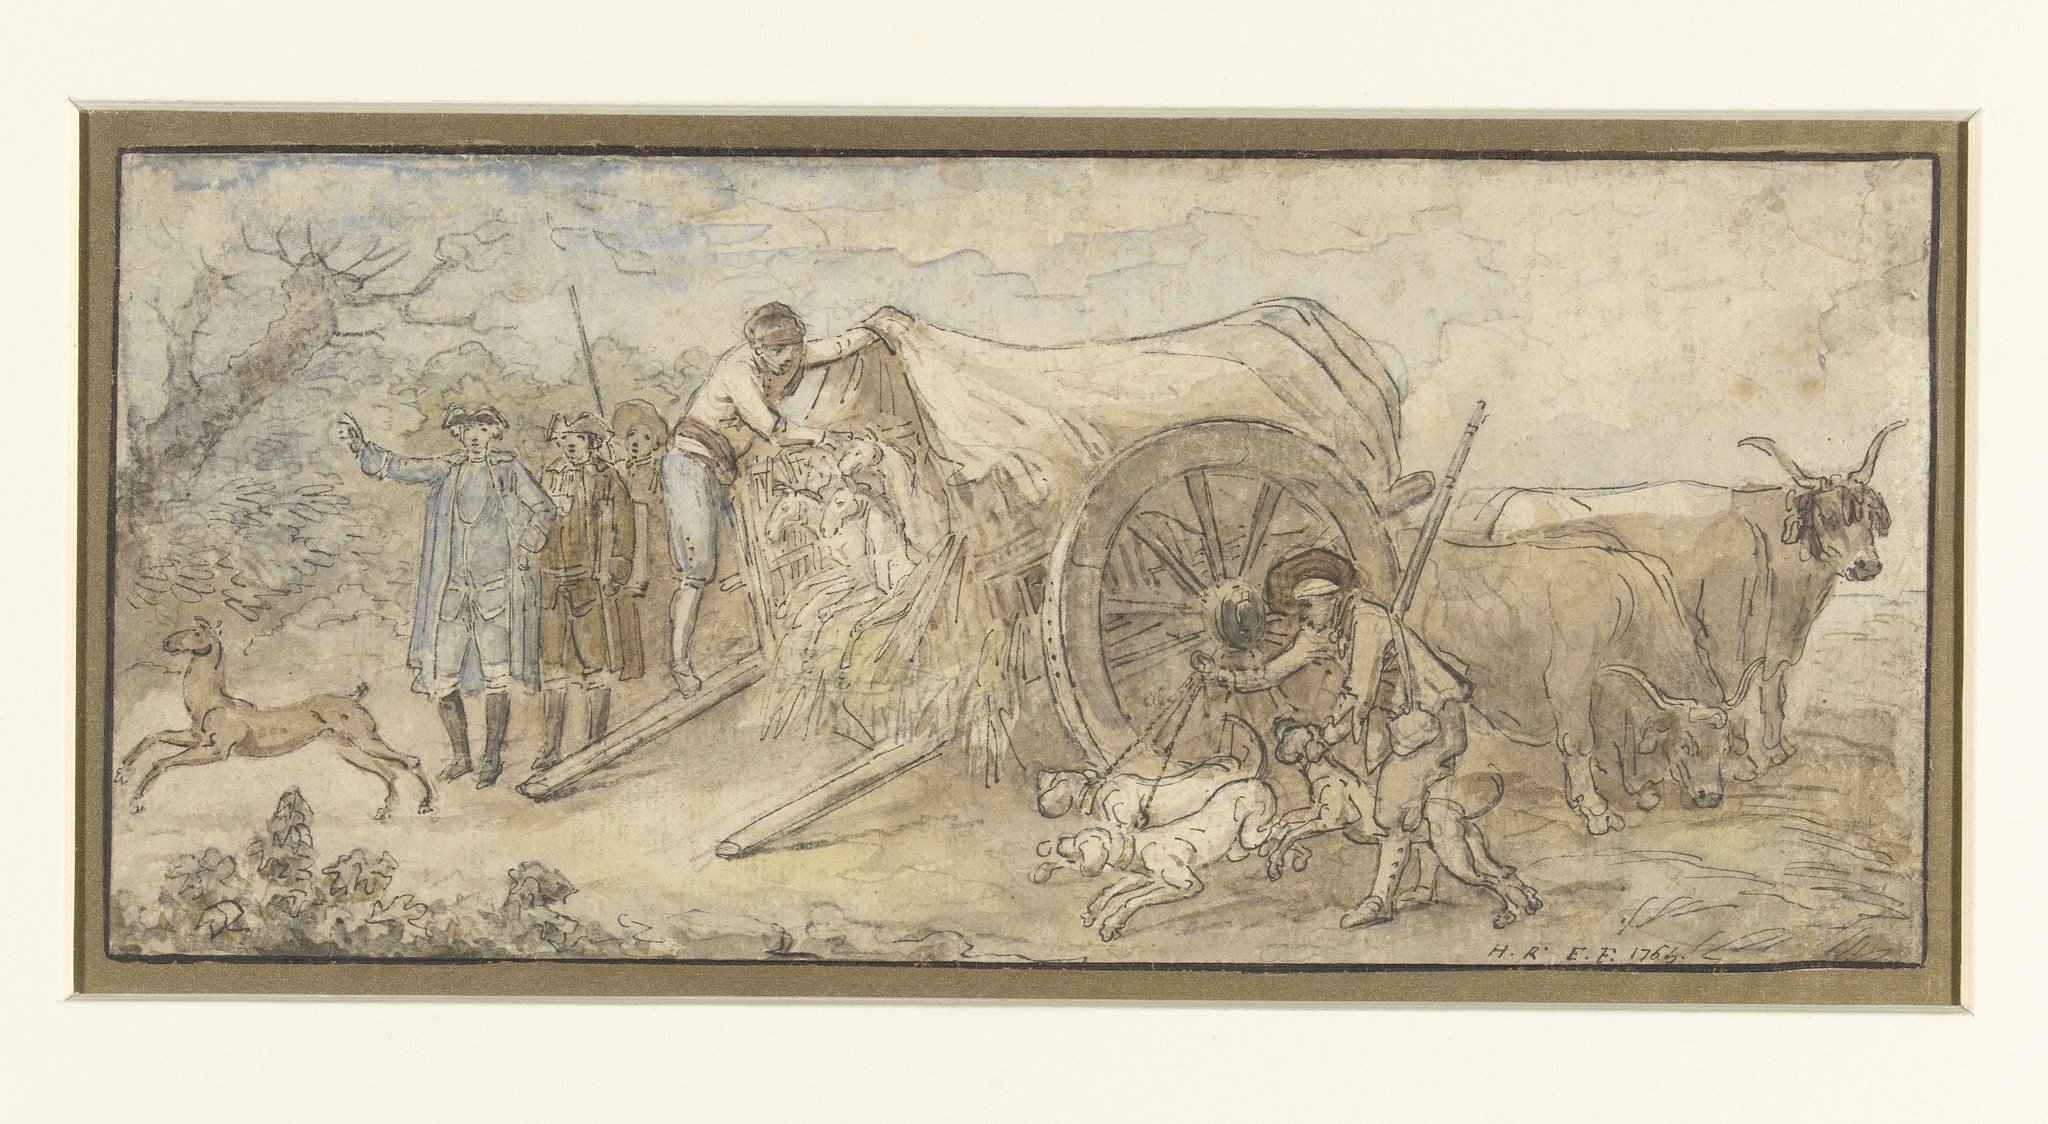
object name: drawing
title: Huifkar in de Campagna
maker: hubert robert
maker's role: draughtsman, print maker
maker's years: 1733-1808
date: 1765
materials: chalk, ink, paper, watercolor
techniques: brush, pen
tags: hunting dogs, hunter, covered wagon, hooded wagon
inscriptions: collector's mark, verso, lower right: Lugt 2228, monogram and date, recto, lower right, pen and brown ink: ‘H. R E. F. 1765’